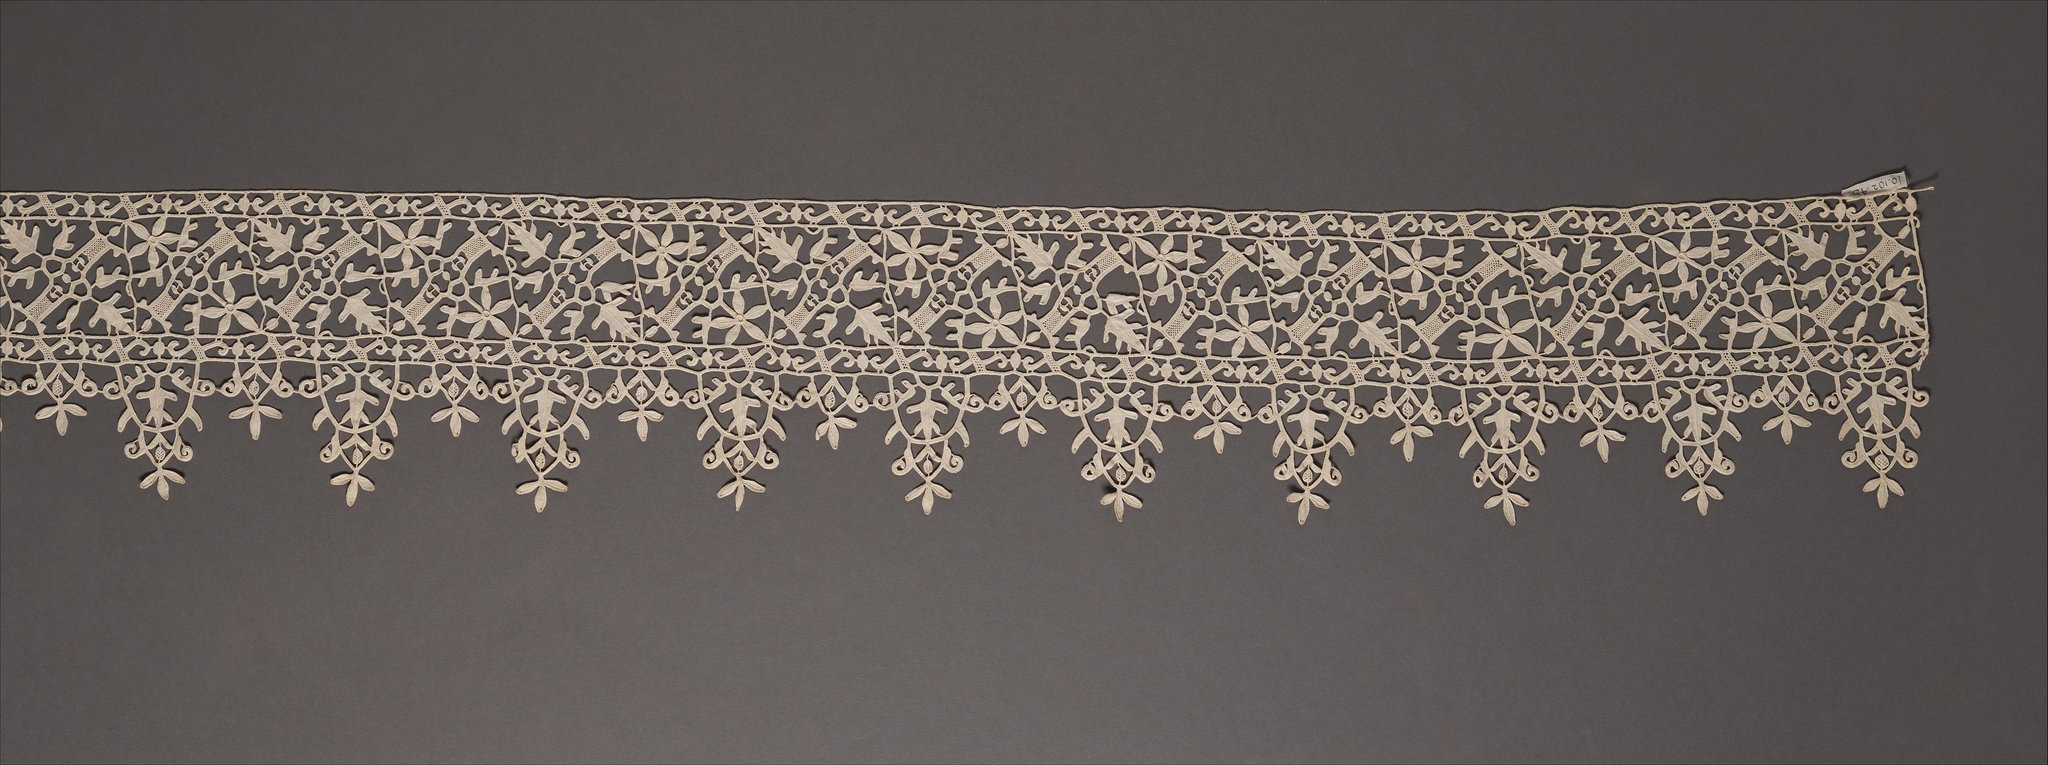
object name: fragment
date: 1601-1700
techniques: lace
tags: leaves